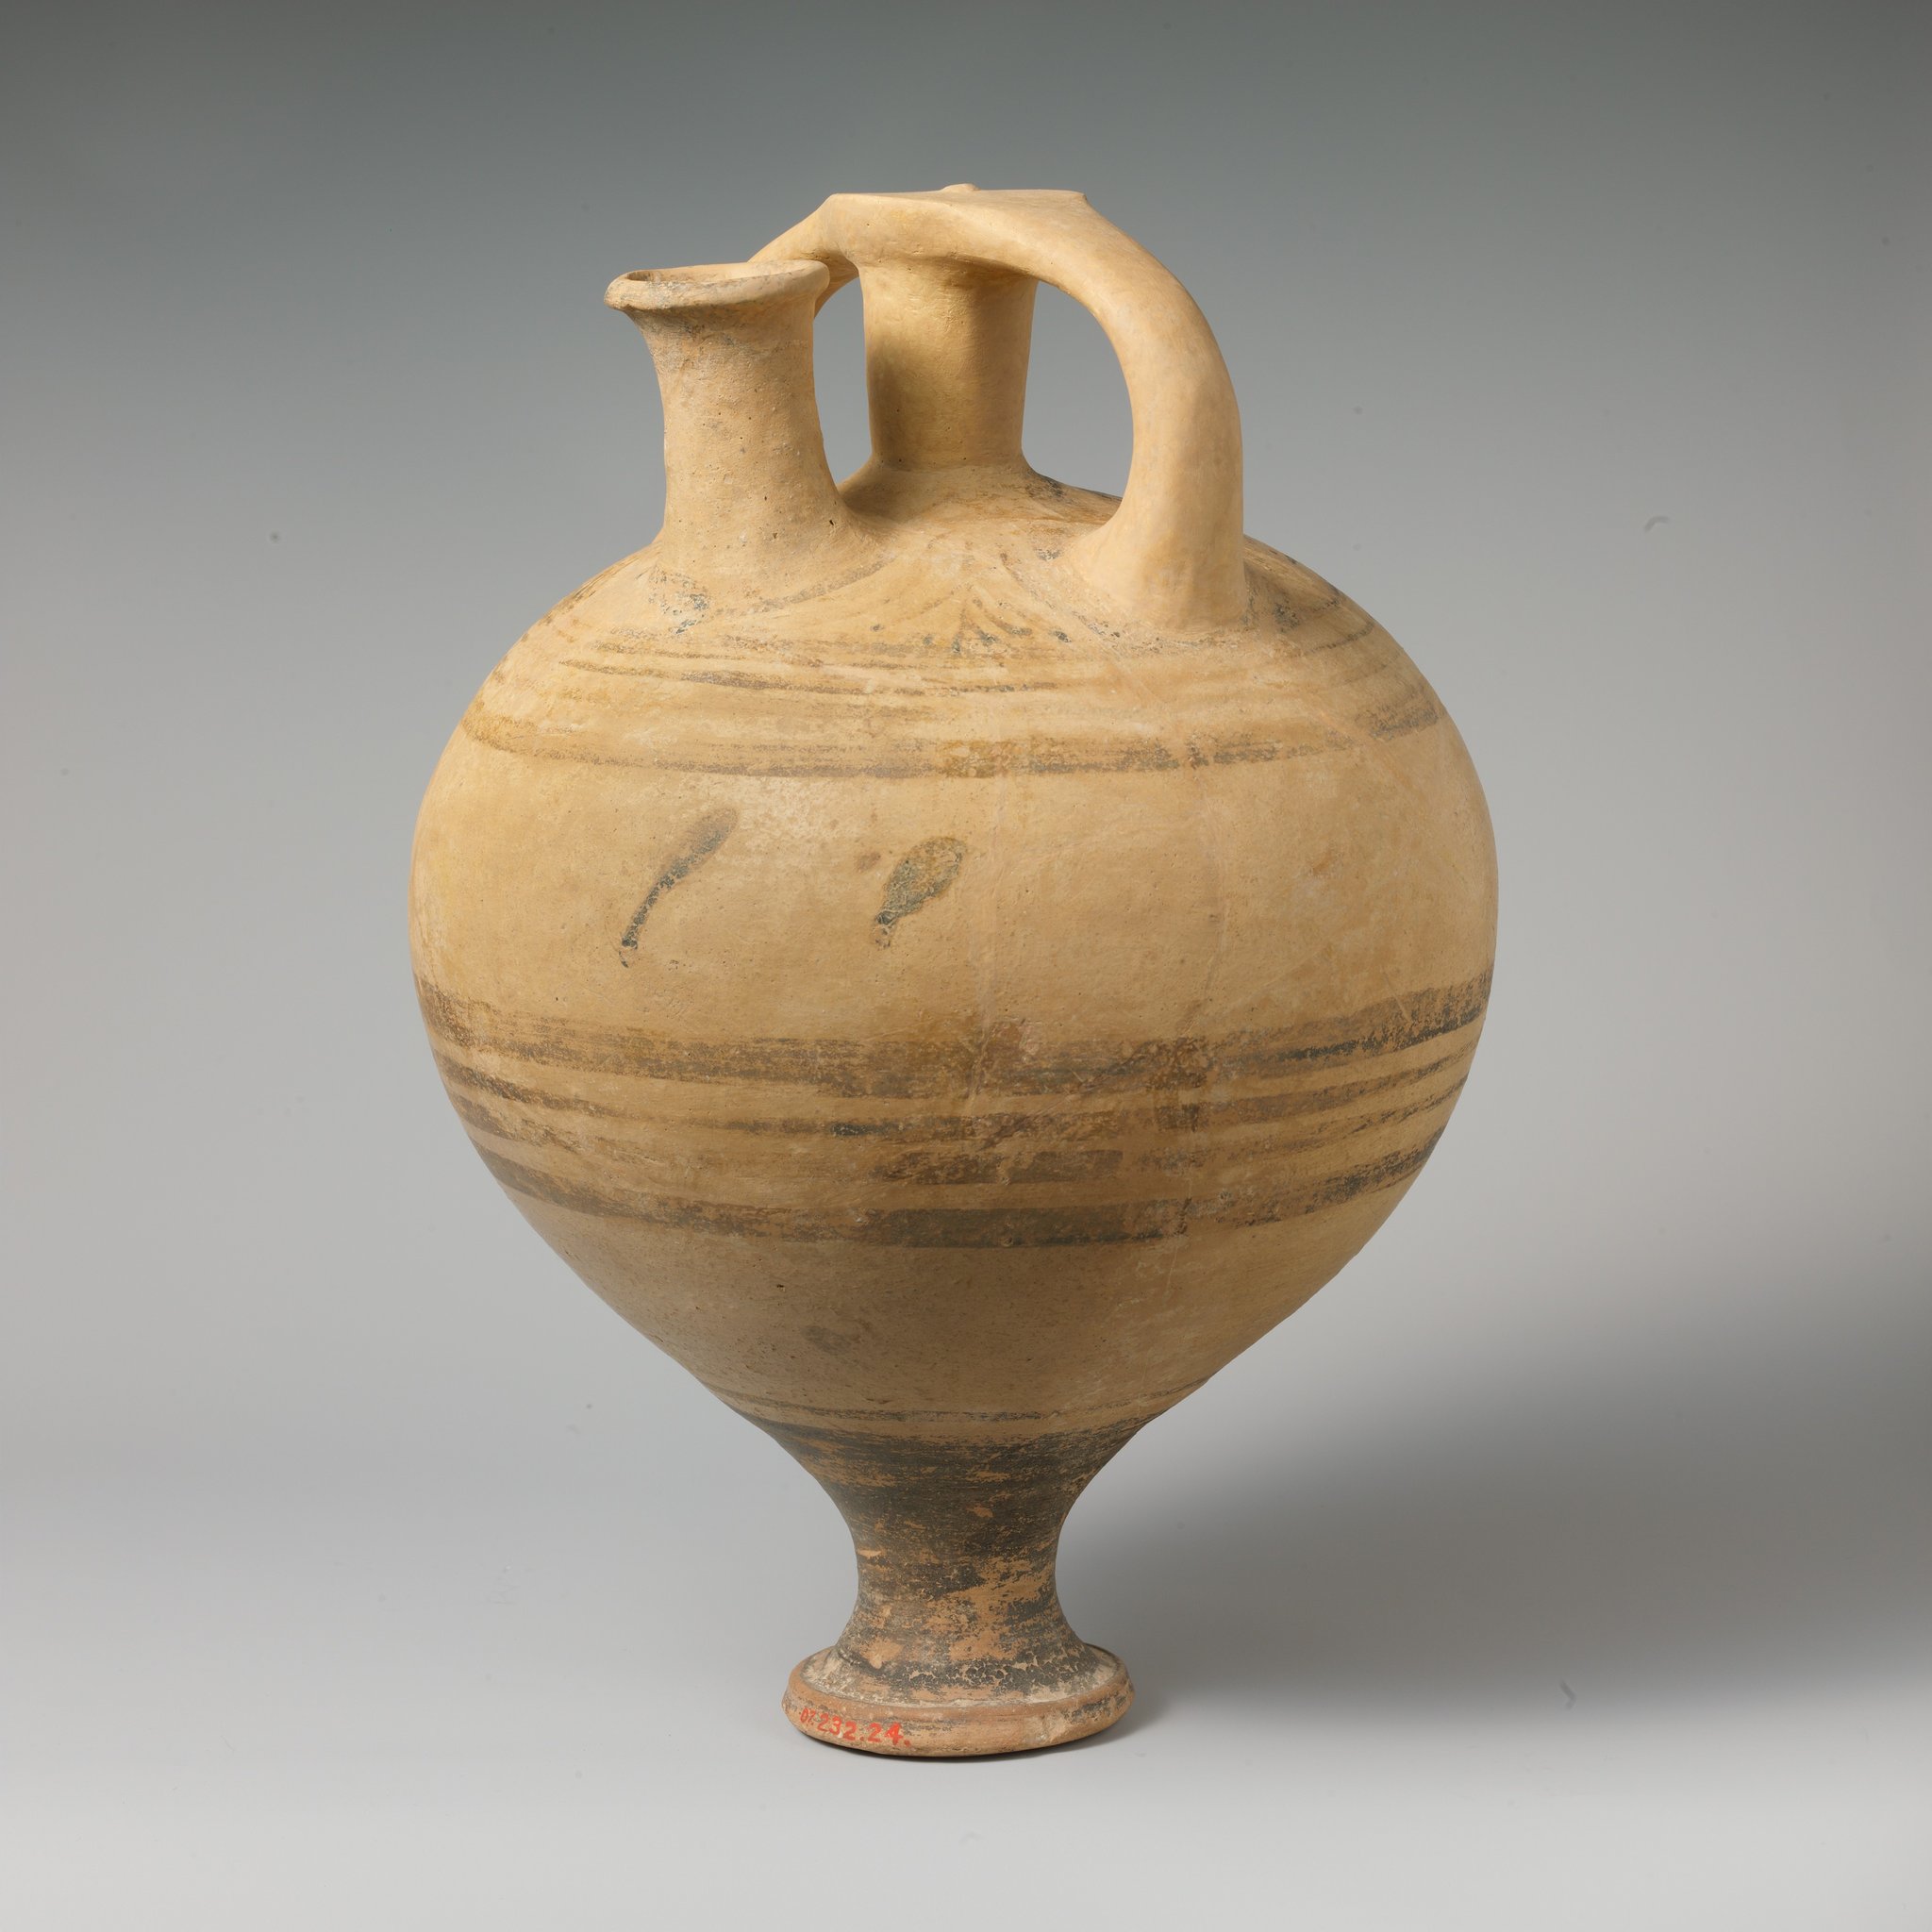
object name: false necked jar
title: Terracotta stirrup jar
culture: minoan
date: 1400-1200 BCE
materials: terracotta